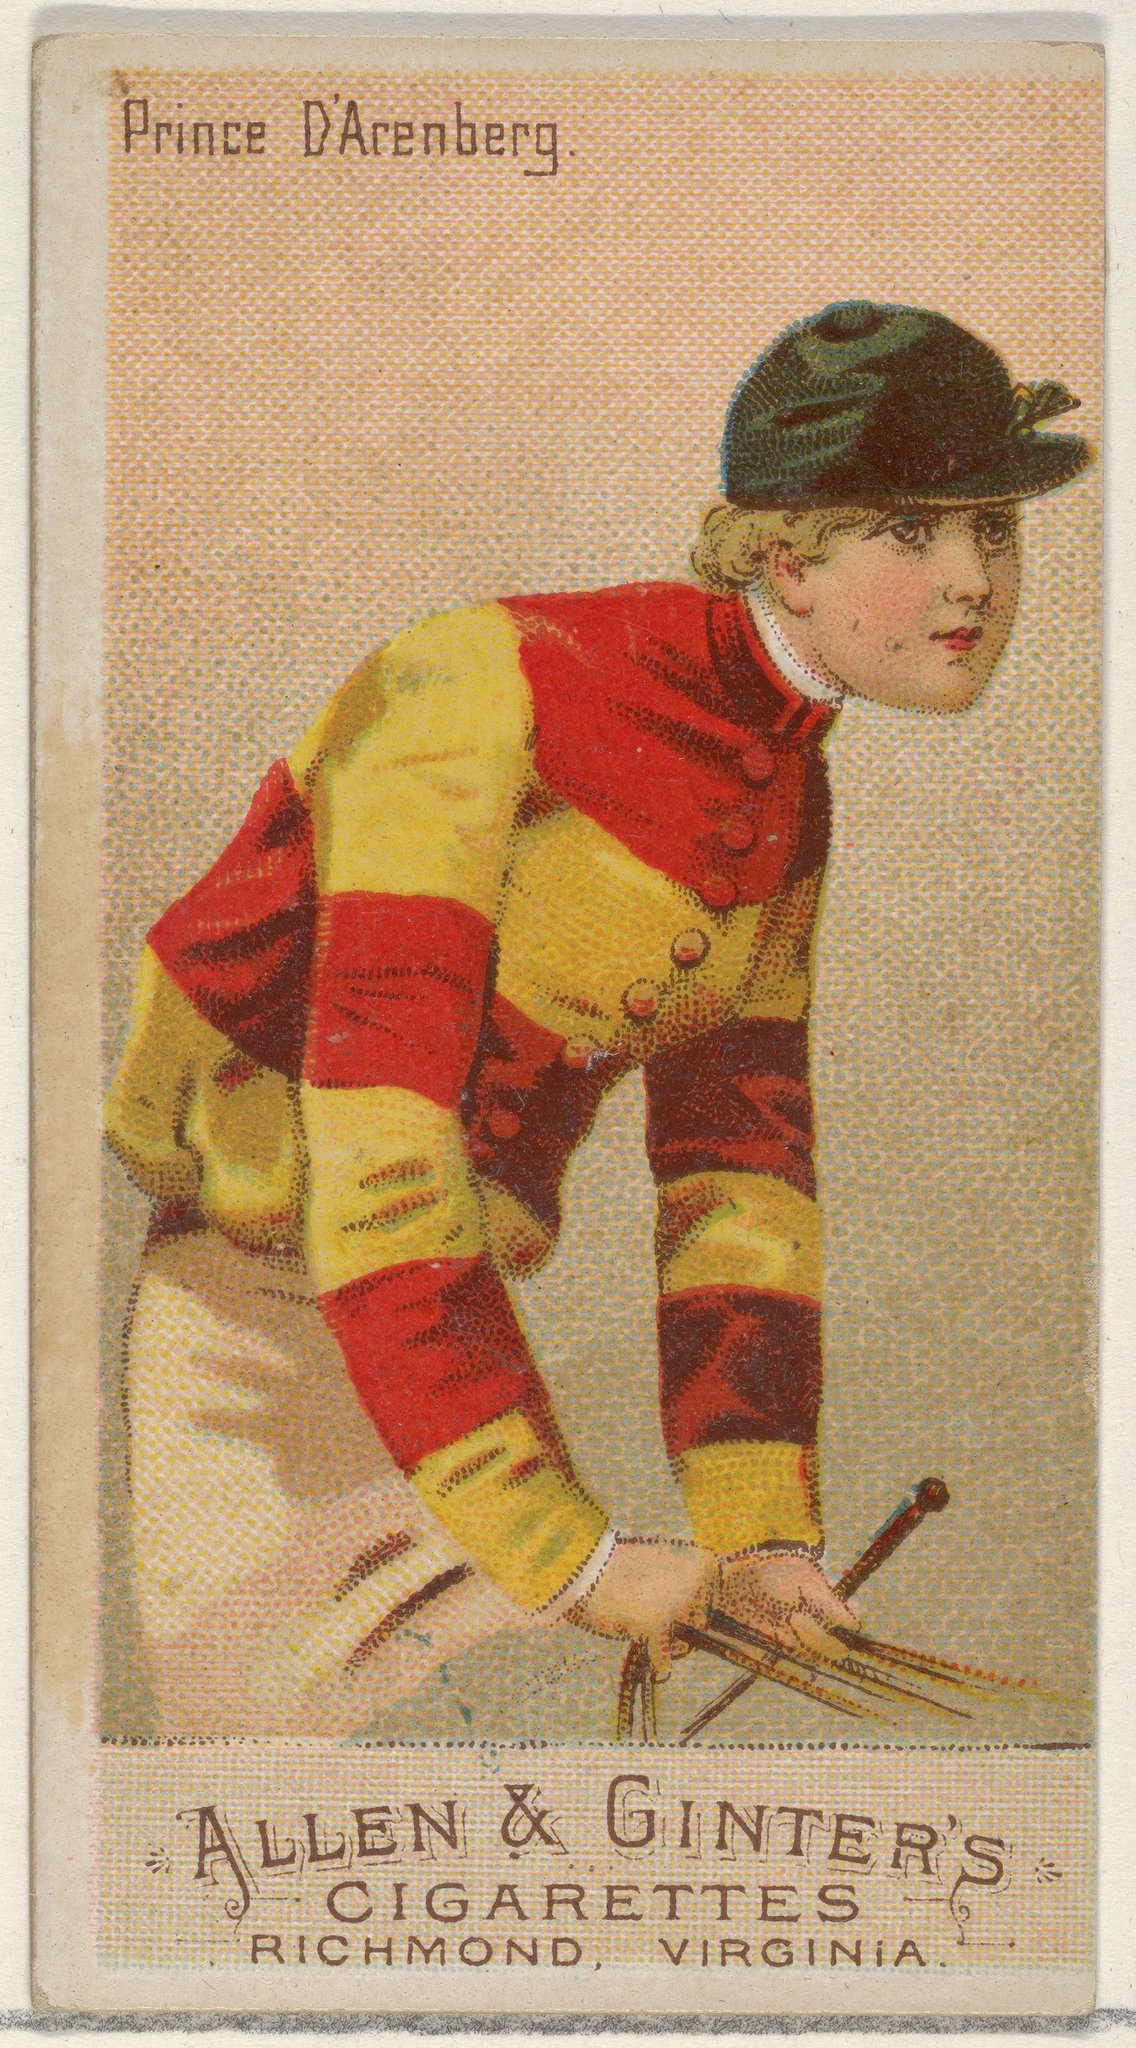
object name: print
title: Prince D'Arenberg, from the Racing Colors of the World series (N22a) for Allen & Ginter Cigarettes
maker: allen & ginter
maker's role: publisher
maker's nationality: american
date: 1888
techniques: color lithograph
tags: men,jockeys